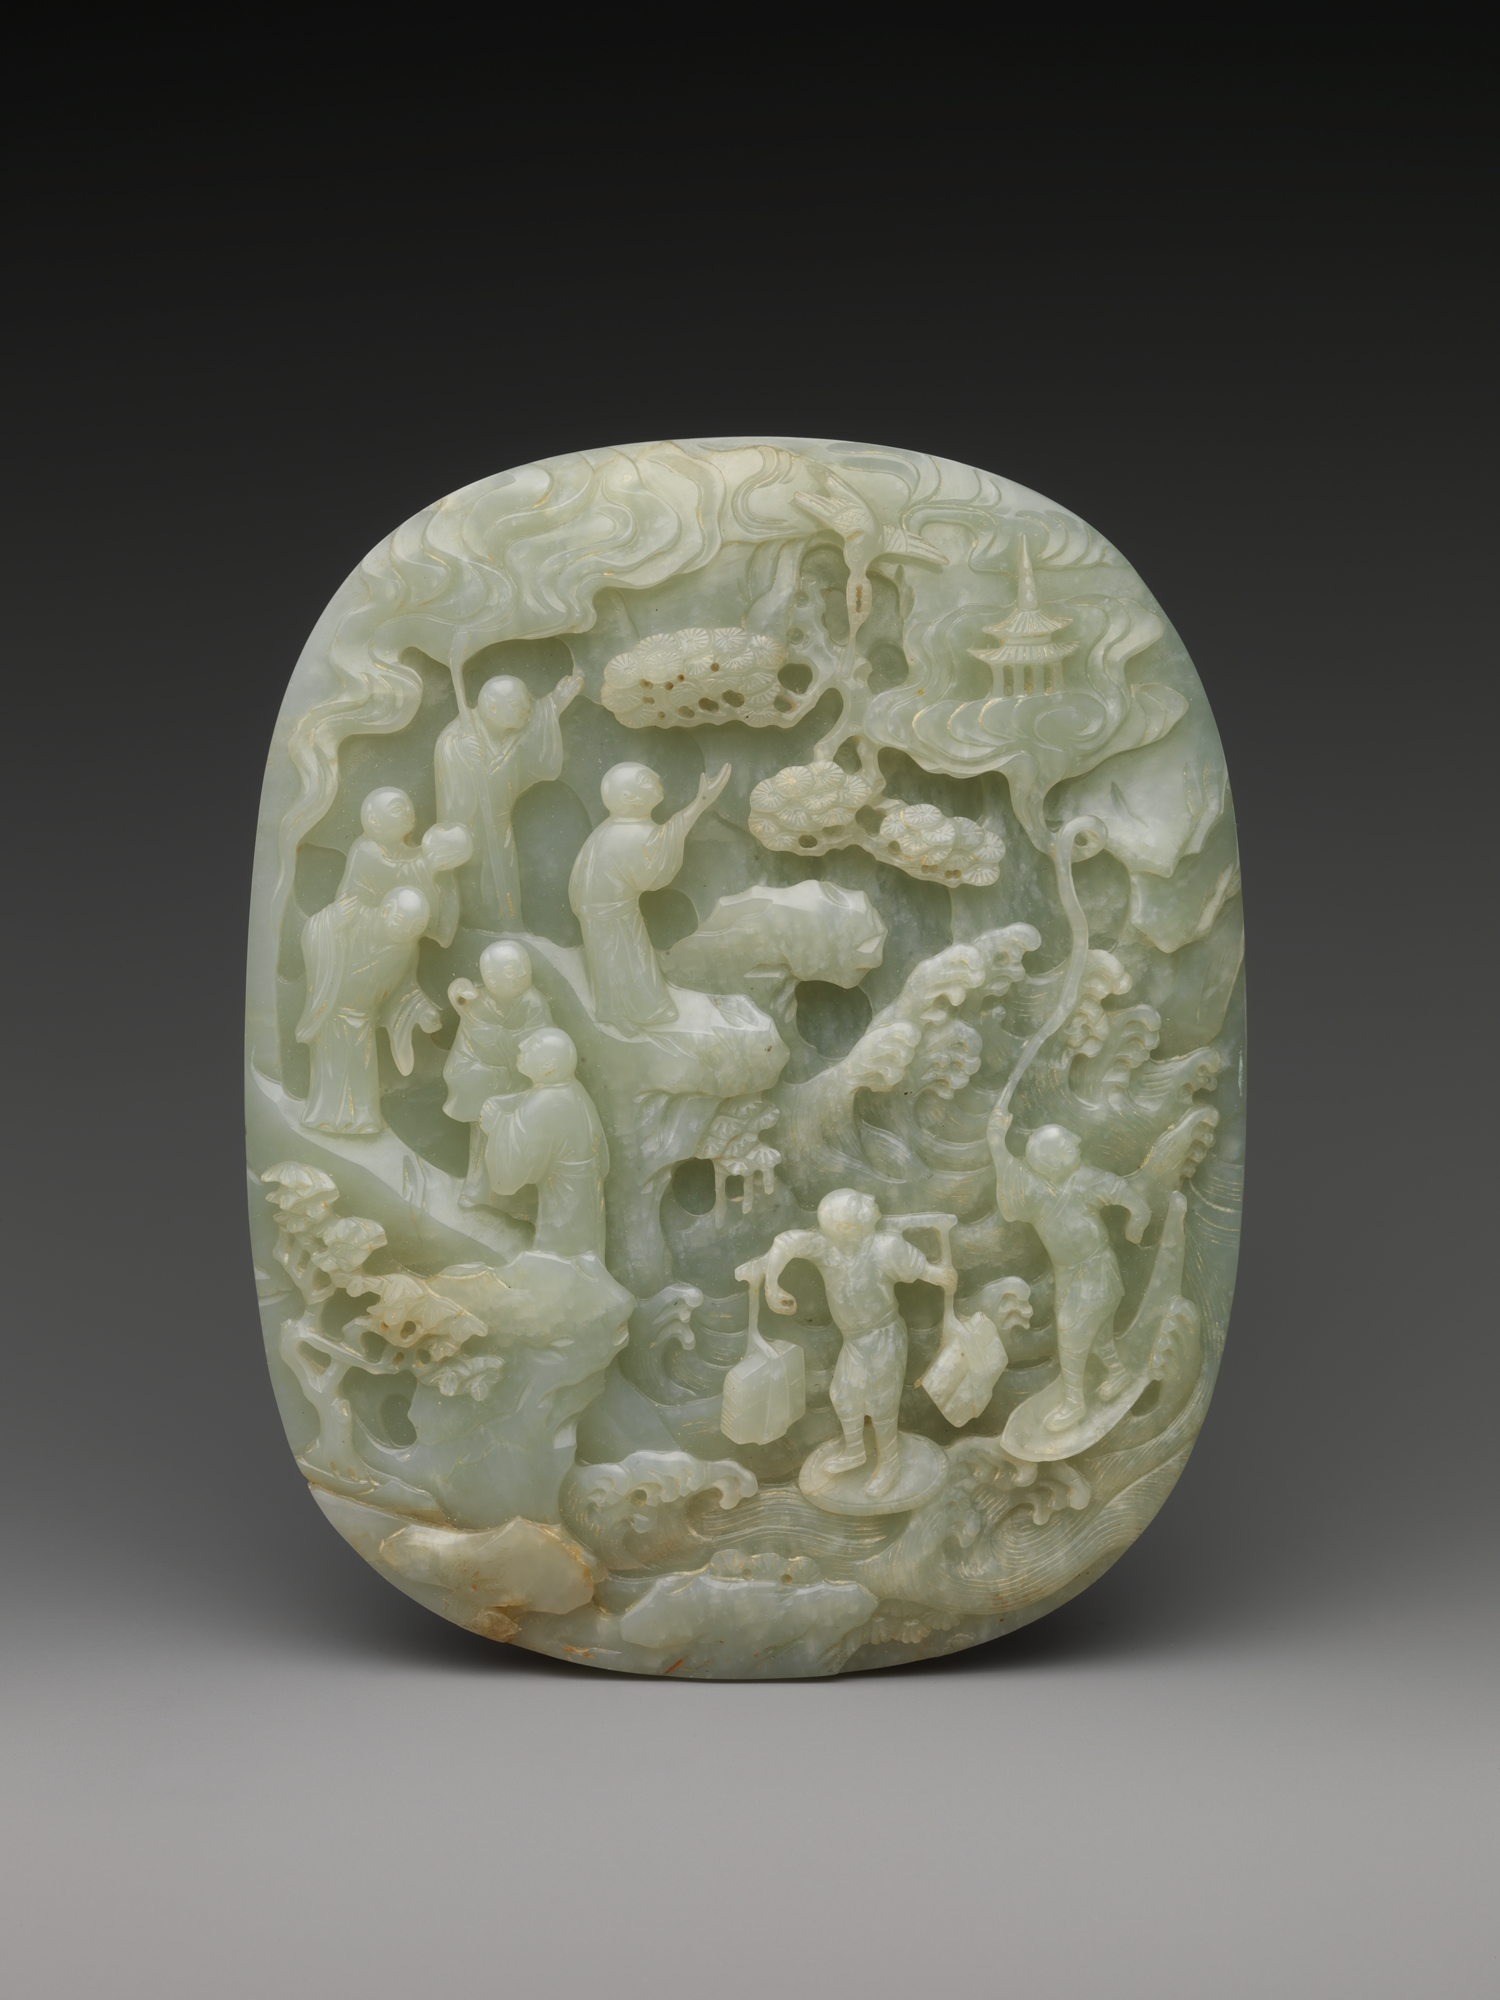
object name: table screen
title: Table screen with landscape scene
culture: chinese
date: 1701-1900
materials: jade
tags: men